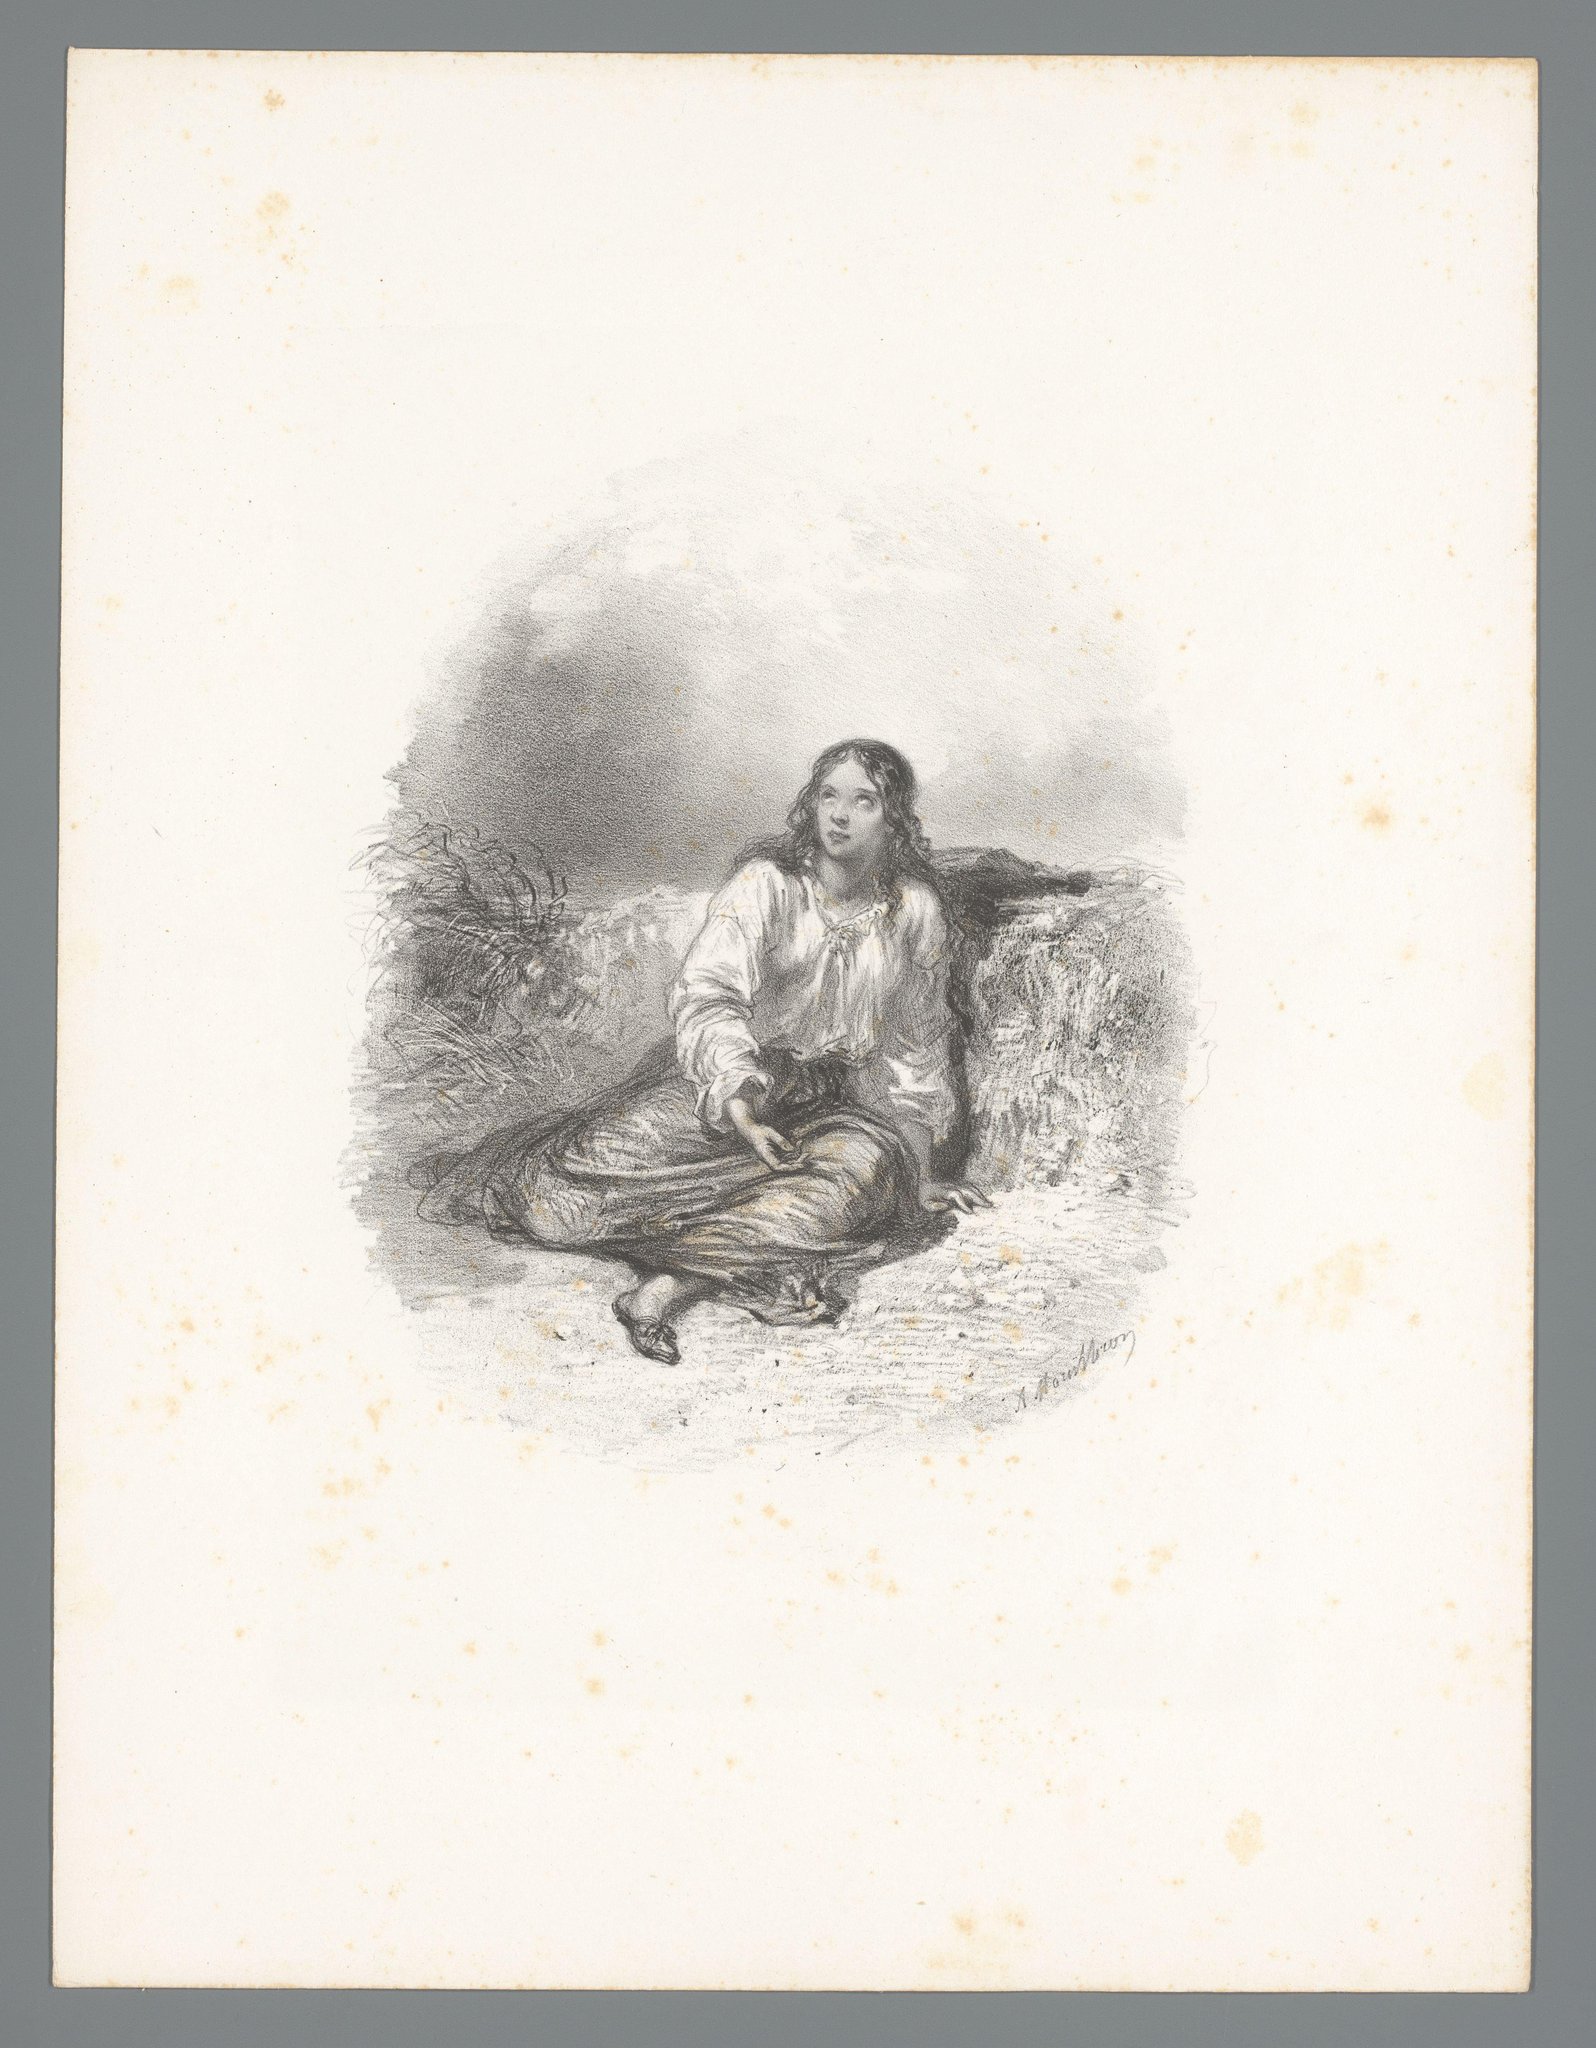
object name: print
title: Zittende vrouw in natuur slaat de ogen op naar boven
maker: adolphe mouilleron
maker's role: draughtsman, print maker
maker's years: 1820-1881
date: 1830-1881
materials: paper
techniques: lithograph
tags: adult woman (+ sitting)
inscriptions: collector's mark: Lugt 964